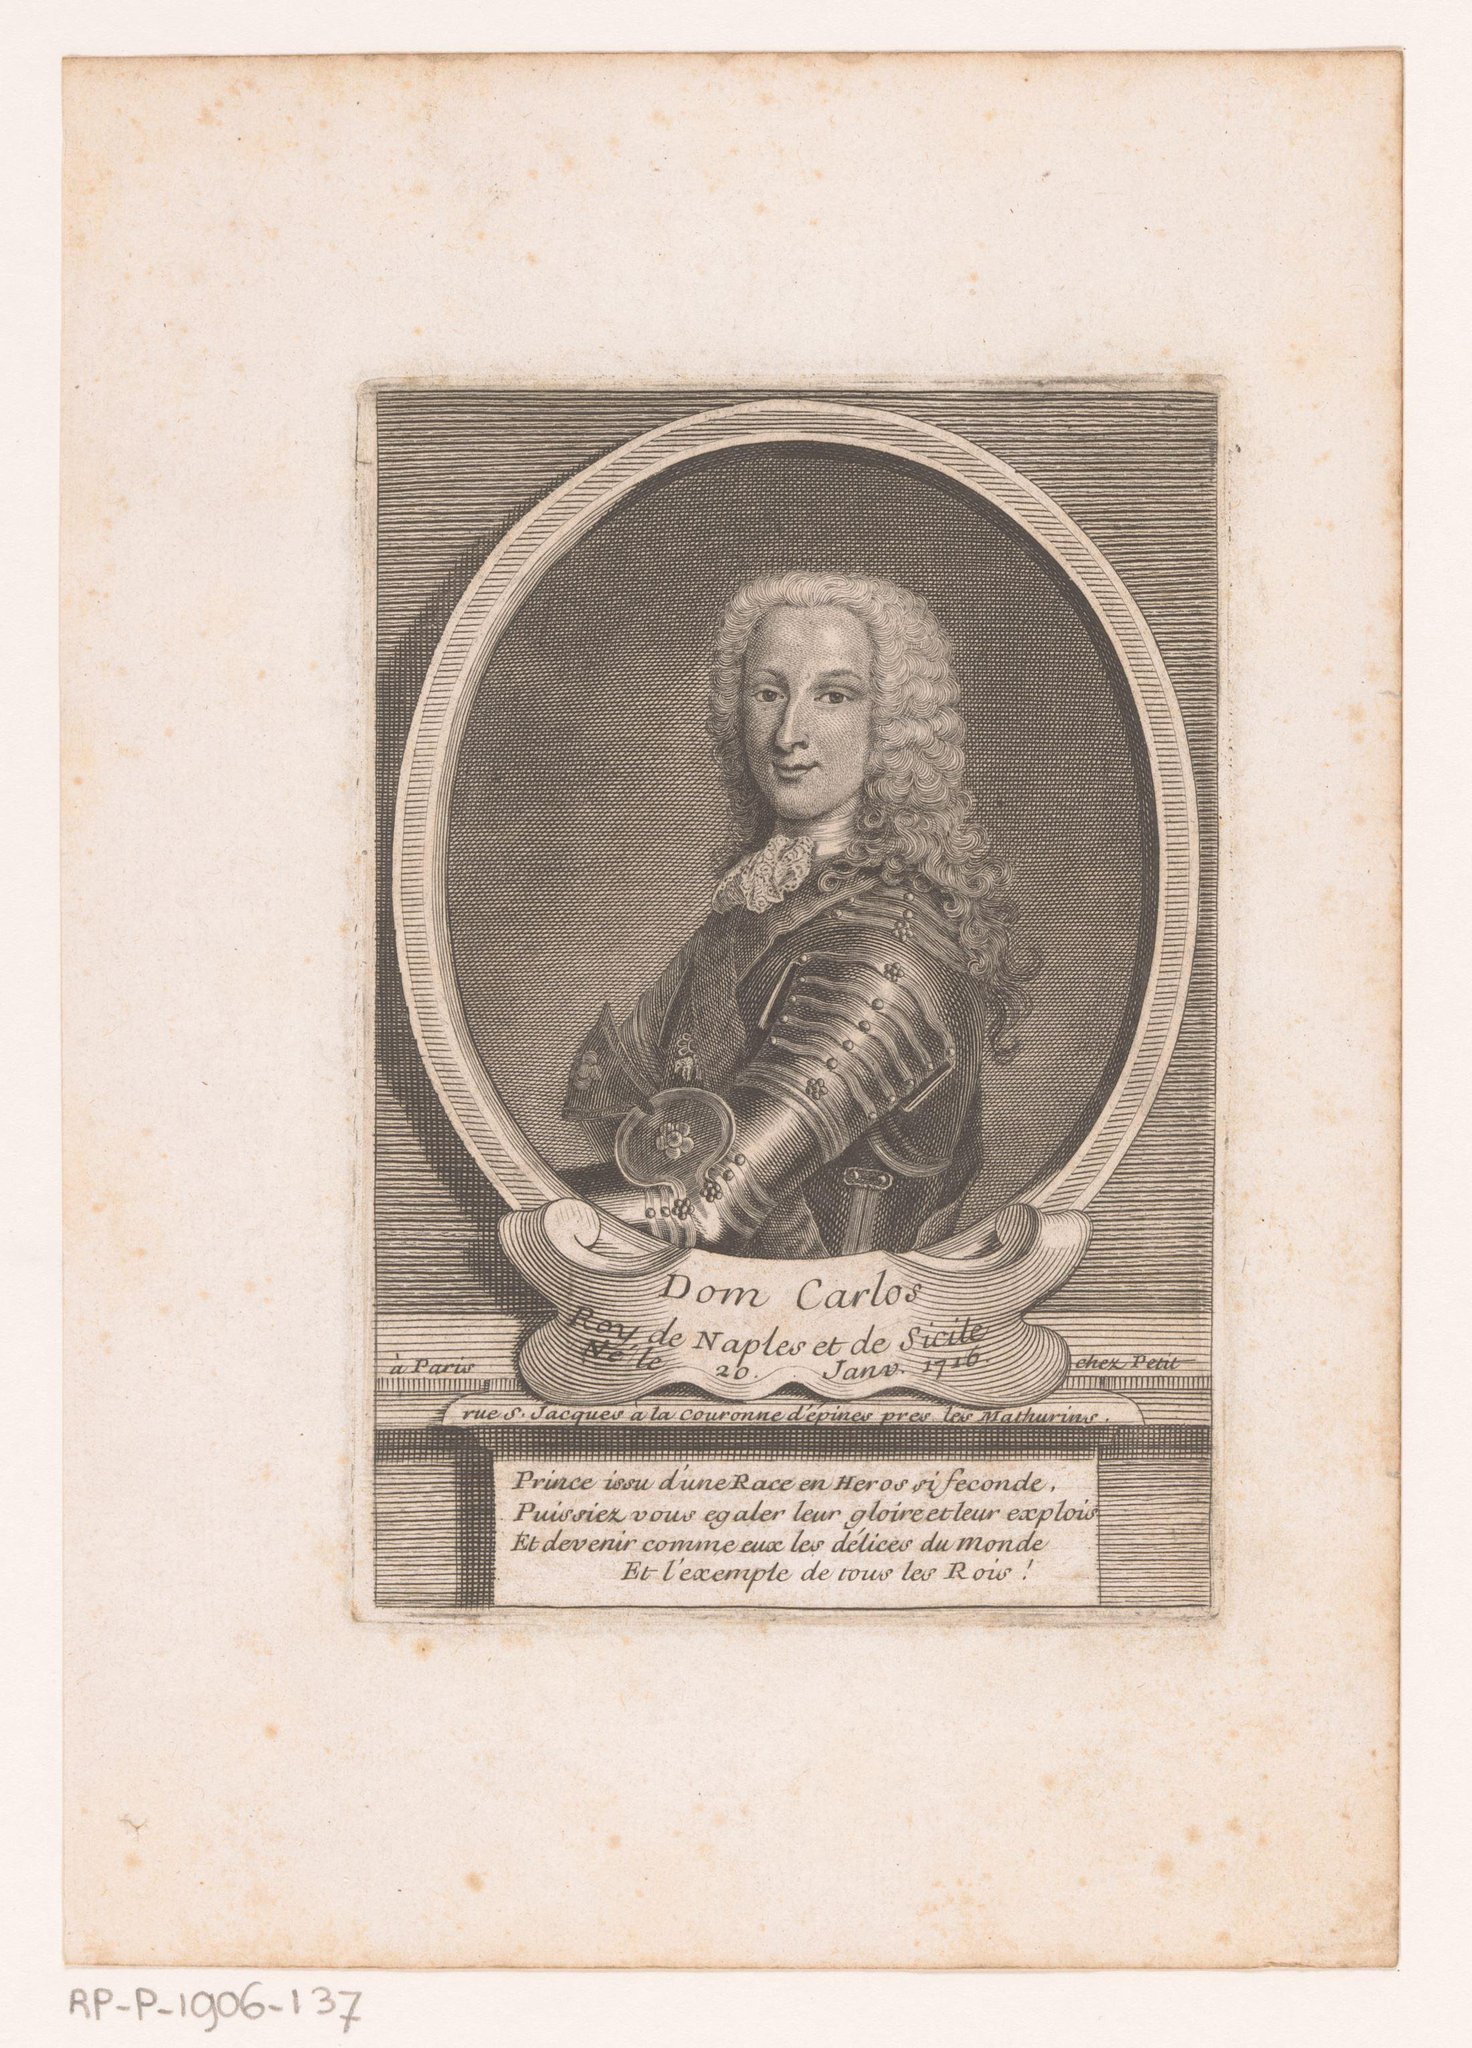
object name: print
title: Dom Carlos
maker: gille edme petit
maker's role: print maker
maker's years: 1694-1760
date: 1704-1760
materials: paper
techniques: engraving, etching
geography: paris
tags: karel iii (koning van spanje (1716-1788), historical persons, king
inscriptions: collector's mark: Lugt 2228